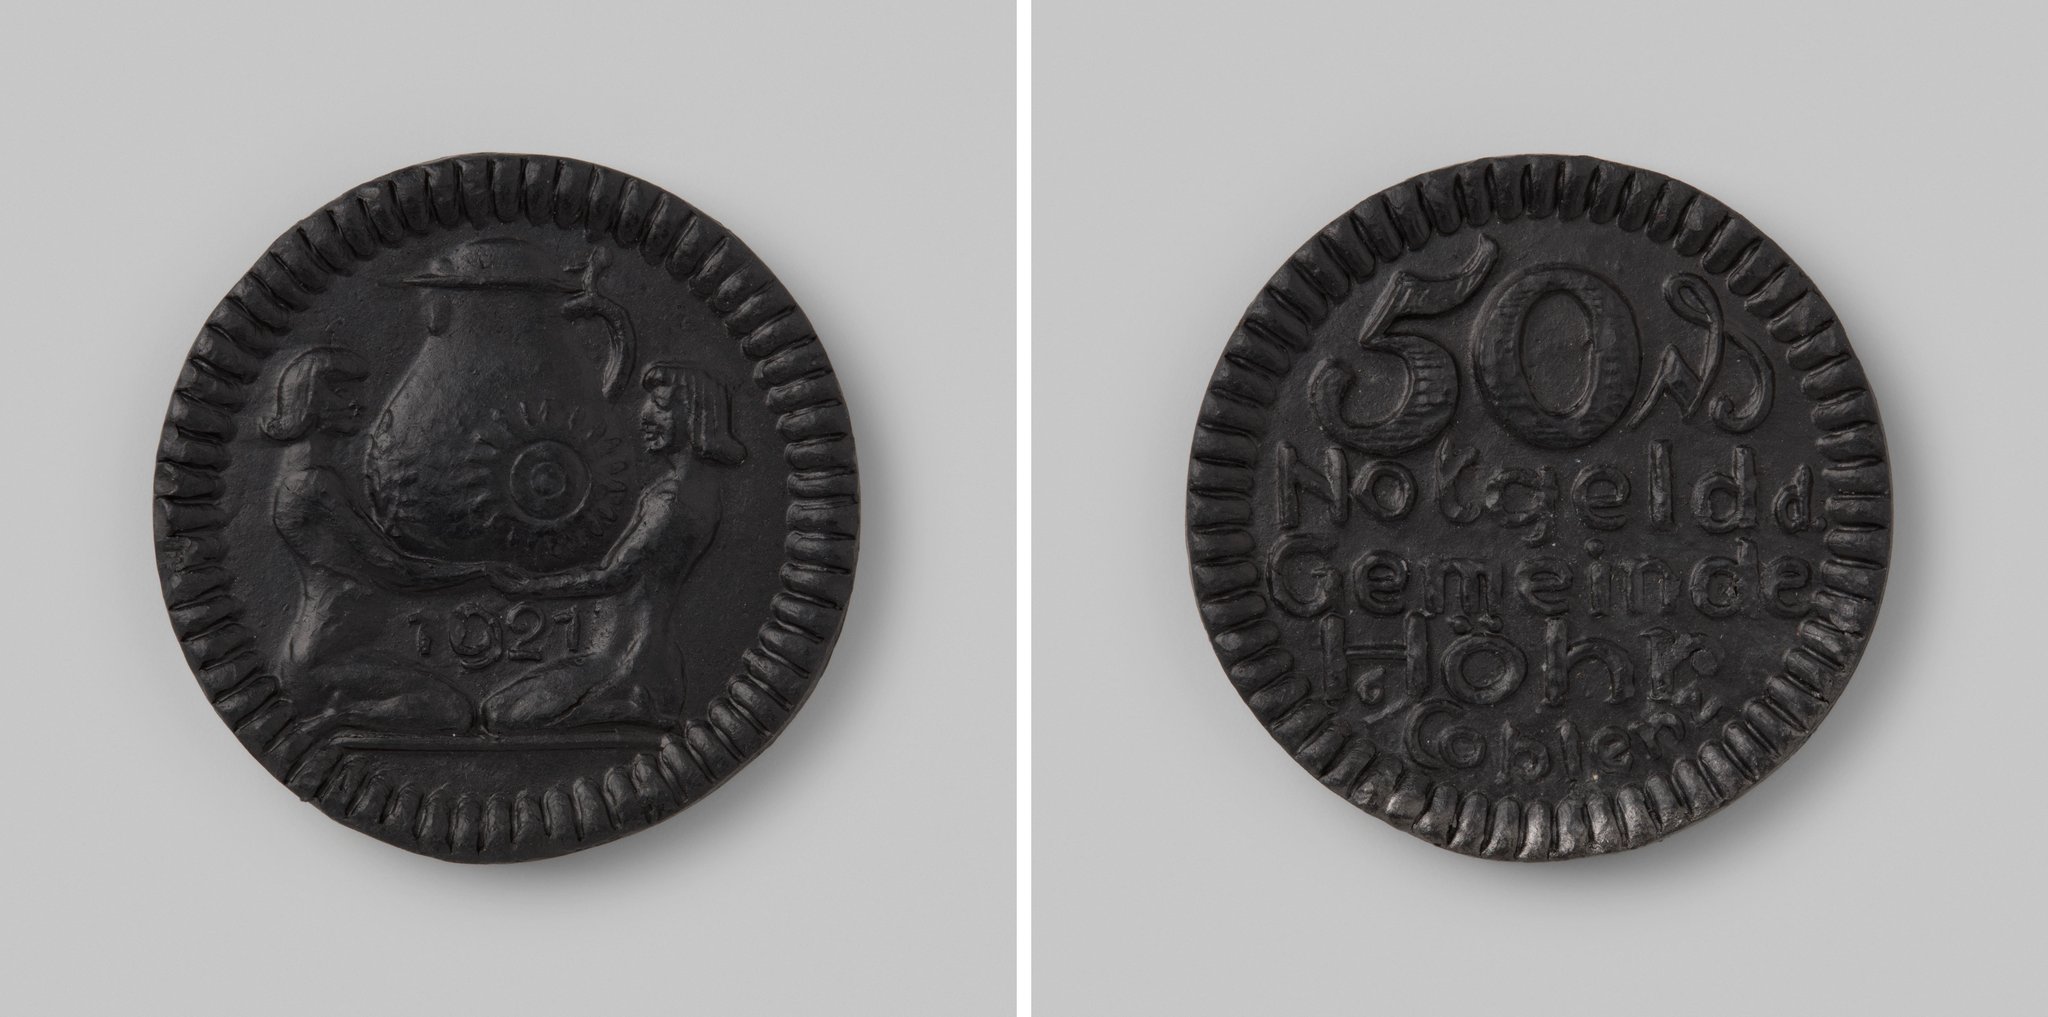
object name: coin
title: 50 mark notgeld uit Duitsland, Höhr, Coblenz, 1921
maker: a. kamp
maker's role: sculptor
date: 1921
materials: porcelain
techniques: casting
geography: höhr-grenzhausen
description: Porseleinen zwart gekleurde pseudomunt. Voorzijde: jongen en meisje die een schenkkan dragen. Tussen beiden jaartal. Keerzijde: waarde-aanduiding in twee regels, waaronder plaats-aanduiding in drie regels. Gladde rand.